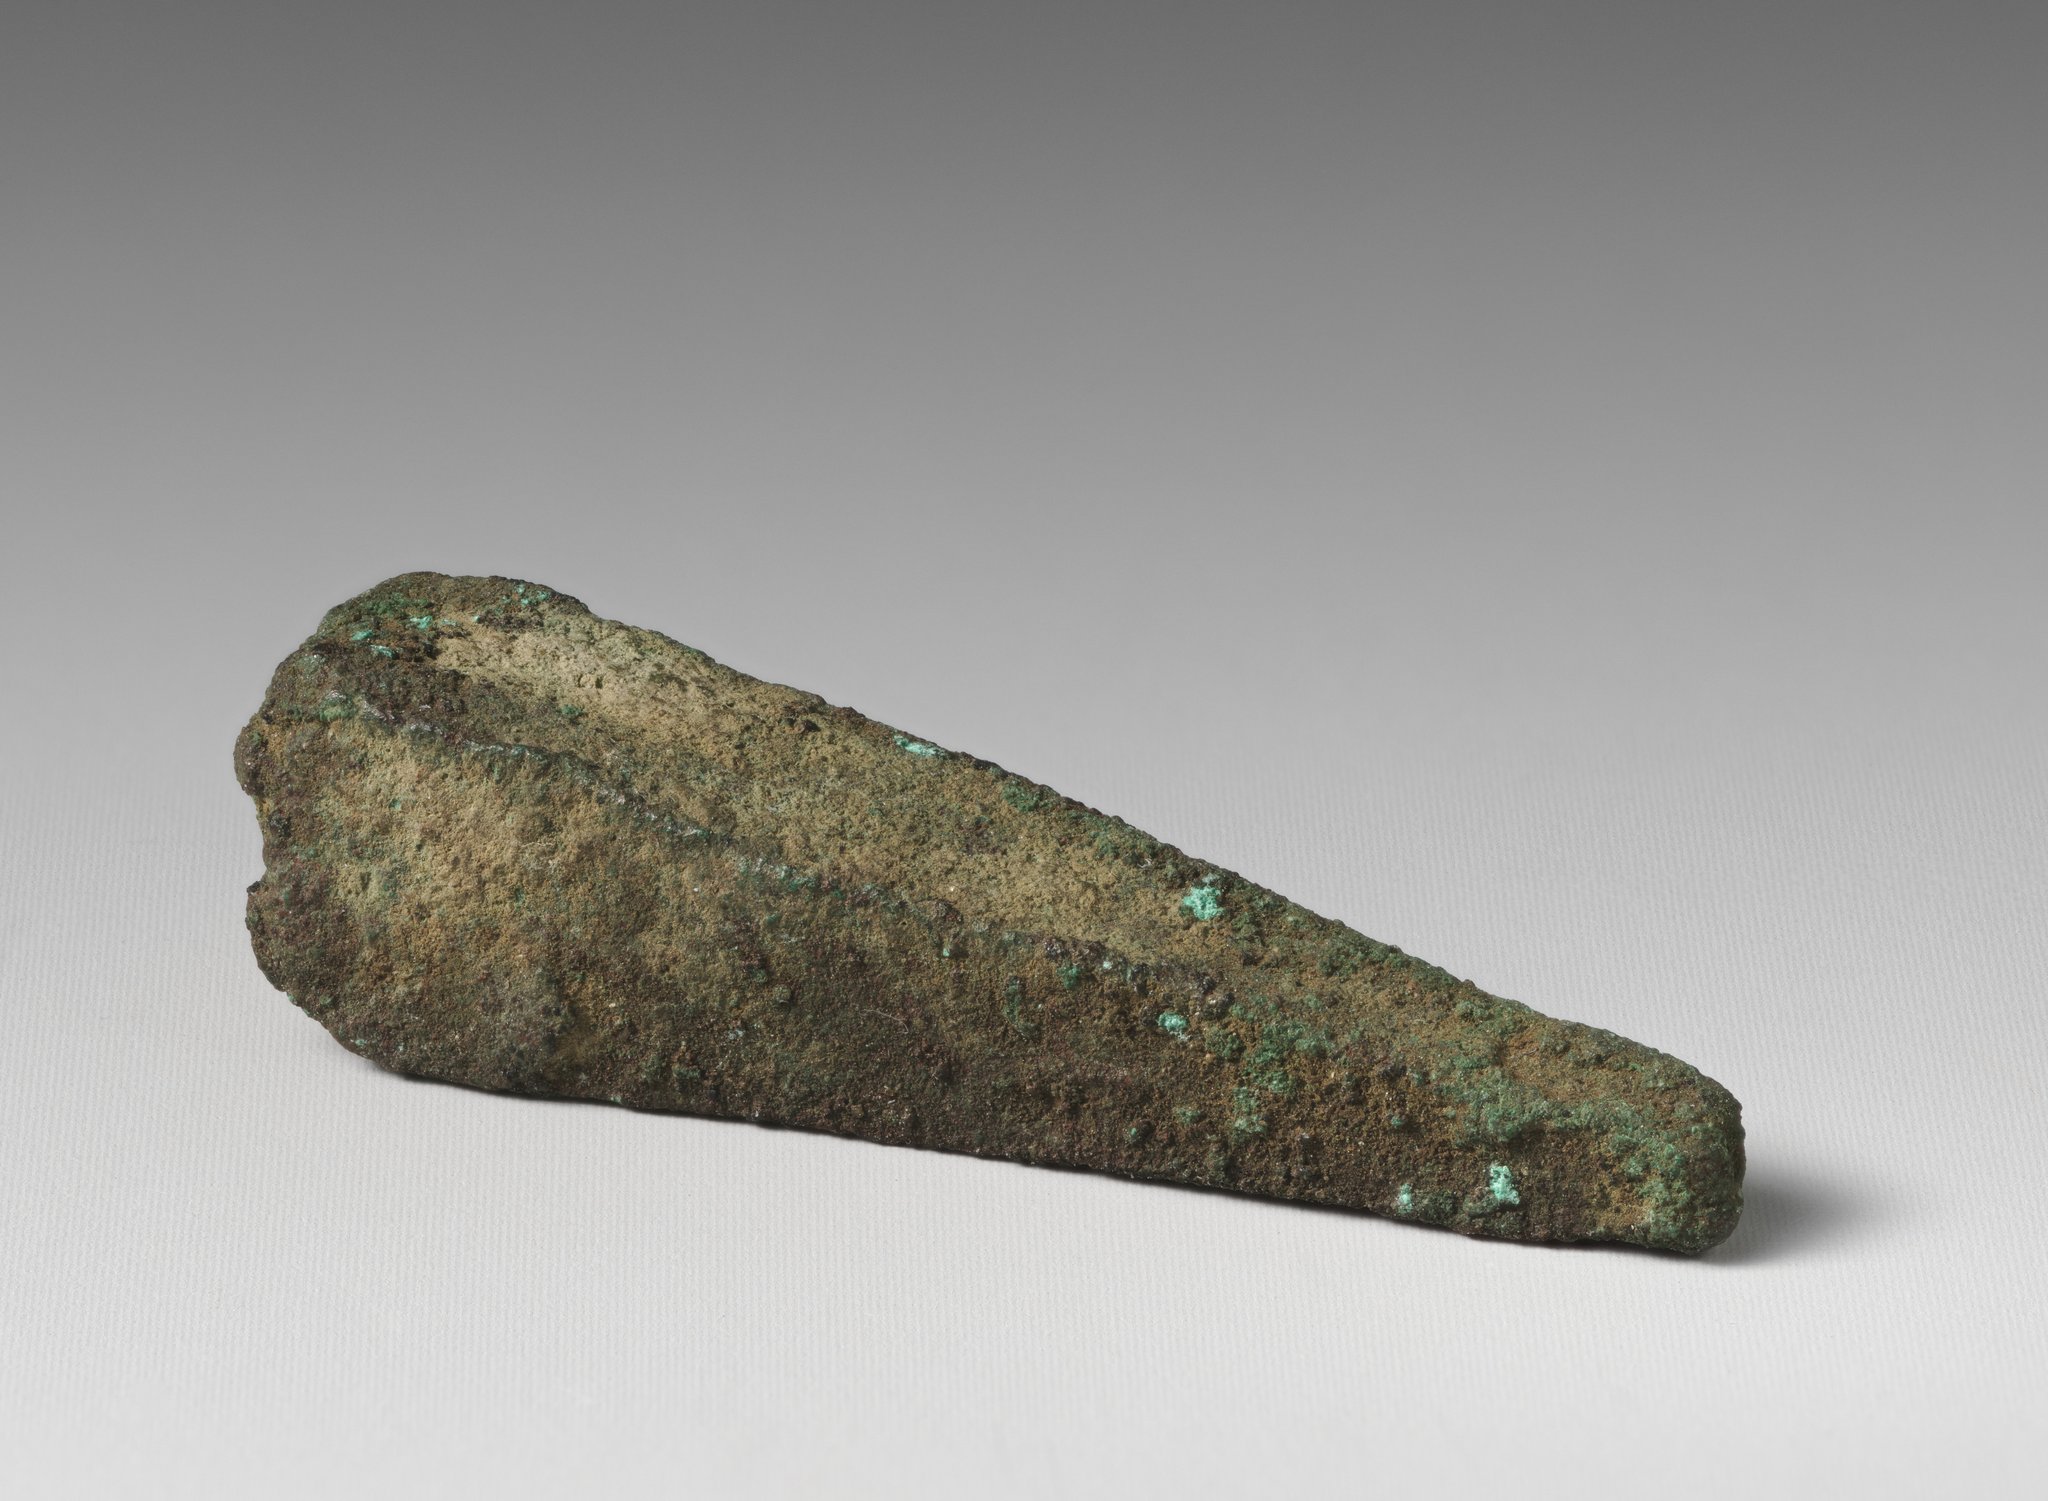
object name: nail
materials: bronze, copper alloy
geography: egypt